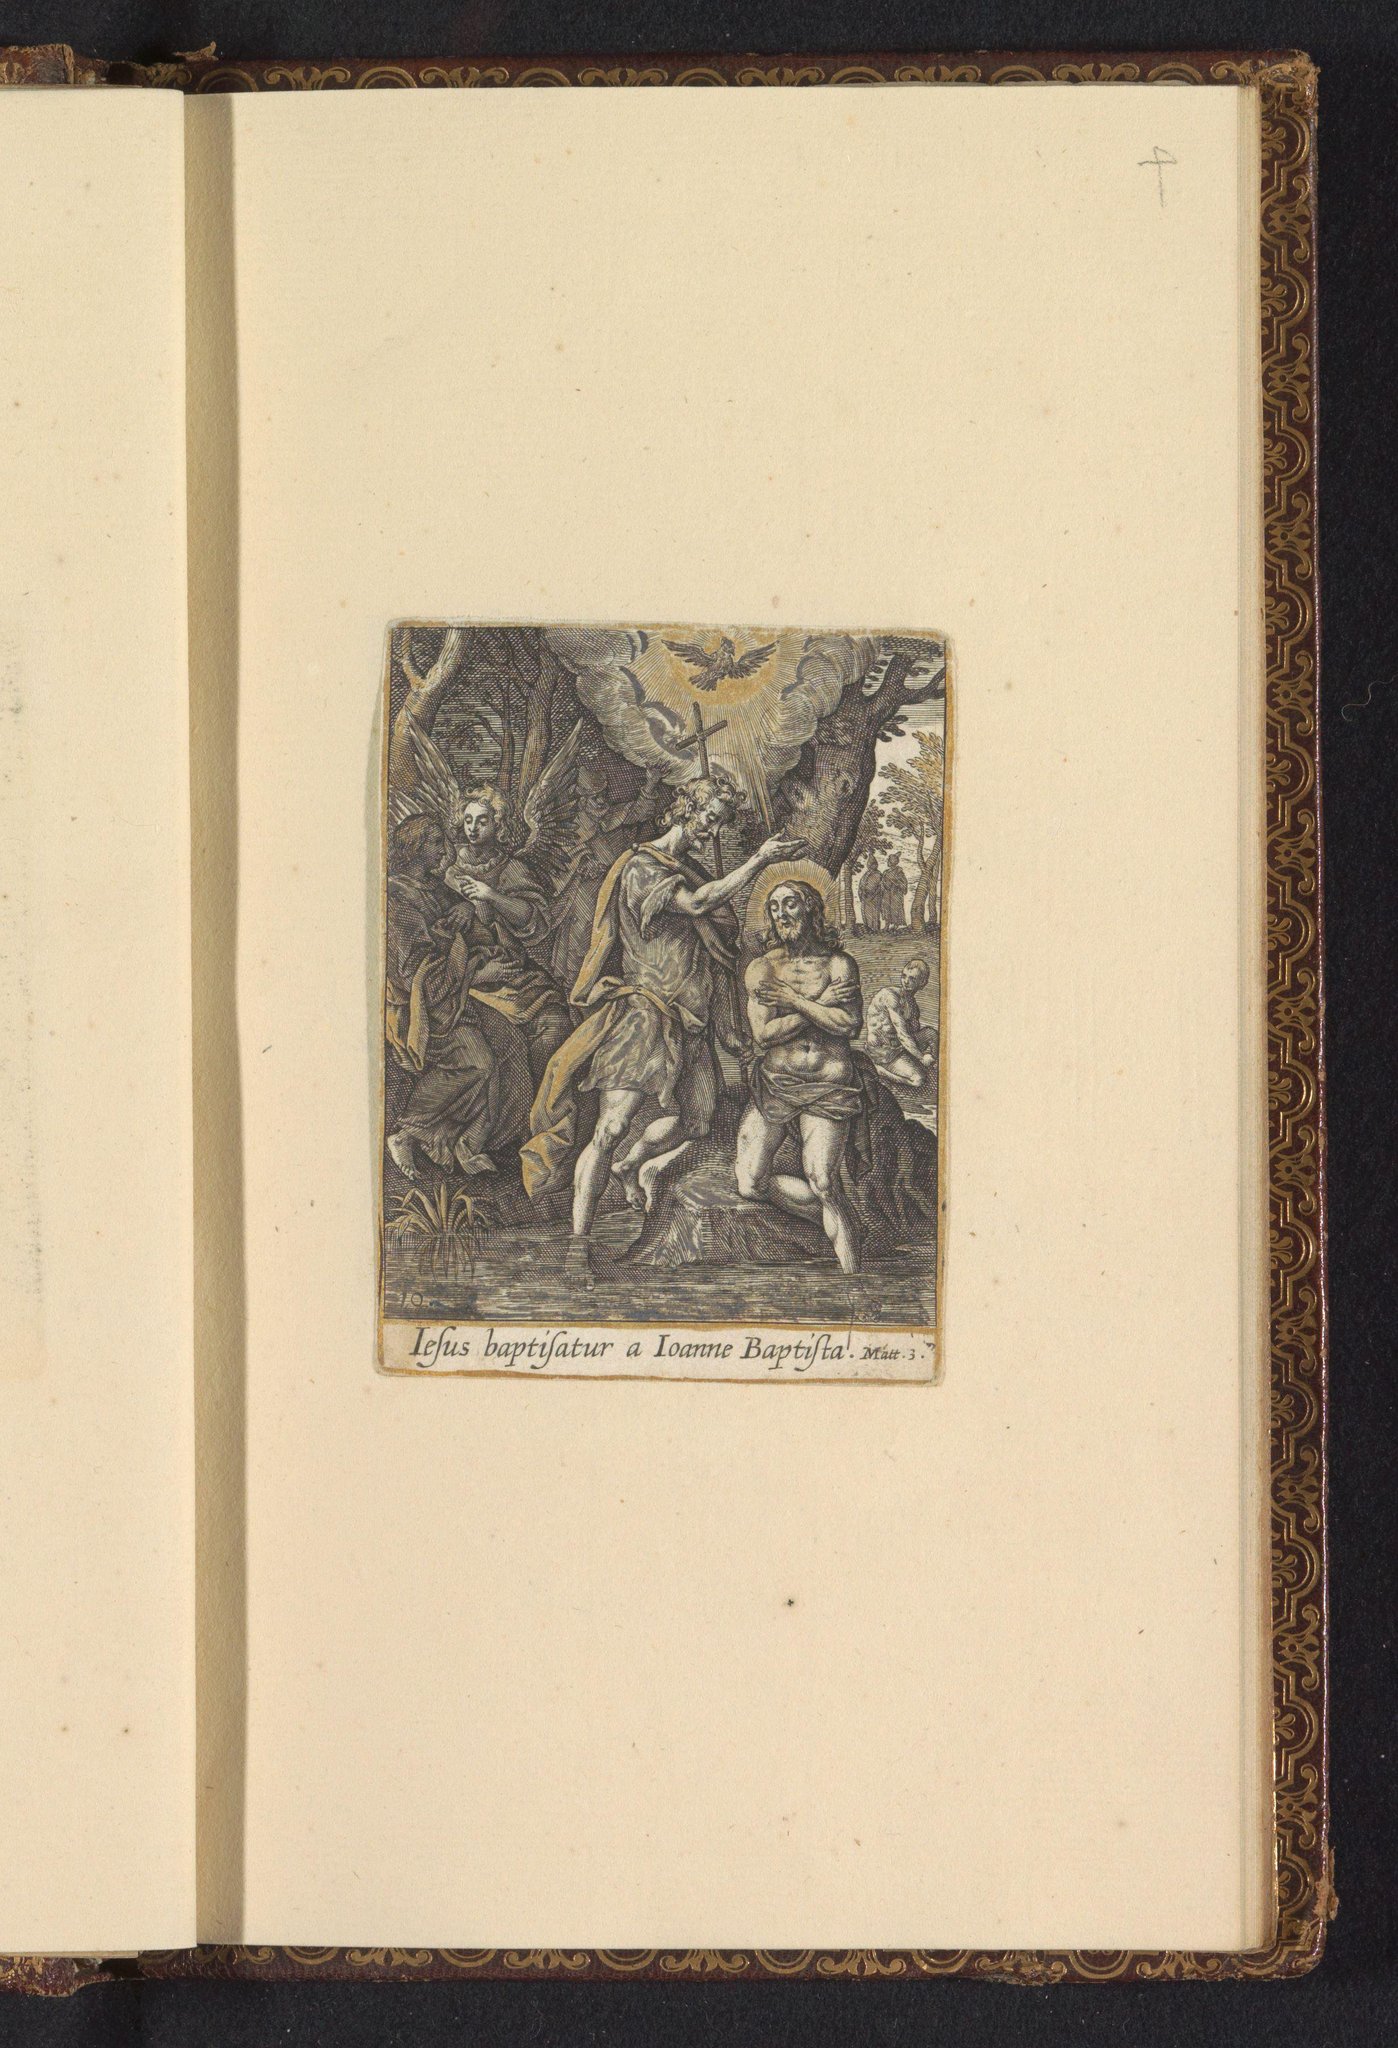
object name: print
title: Doop van Christus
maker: adriaen collaert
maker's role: draughtsman, print maker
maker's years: 1560-1618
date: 1580-1590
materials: gold, paper, silver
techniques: engraving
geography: antwerp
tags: baptism of christ in the river jordan: john the baptist pouring out water on christ's head: the holy ghost descends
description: De gravures van beide reeksen zijn door dezelfde hand gehoogd met goud en zilver. De eerste reeks van 34 (van 35) gravures is een verkleinde versie naar prenten uit een reeks naar Maarten de Vos (nrs. 2-28, 31-33) met toevoeging van drie scènes uit de Wonderen van Christus (nrs. 26, 28, 30).